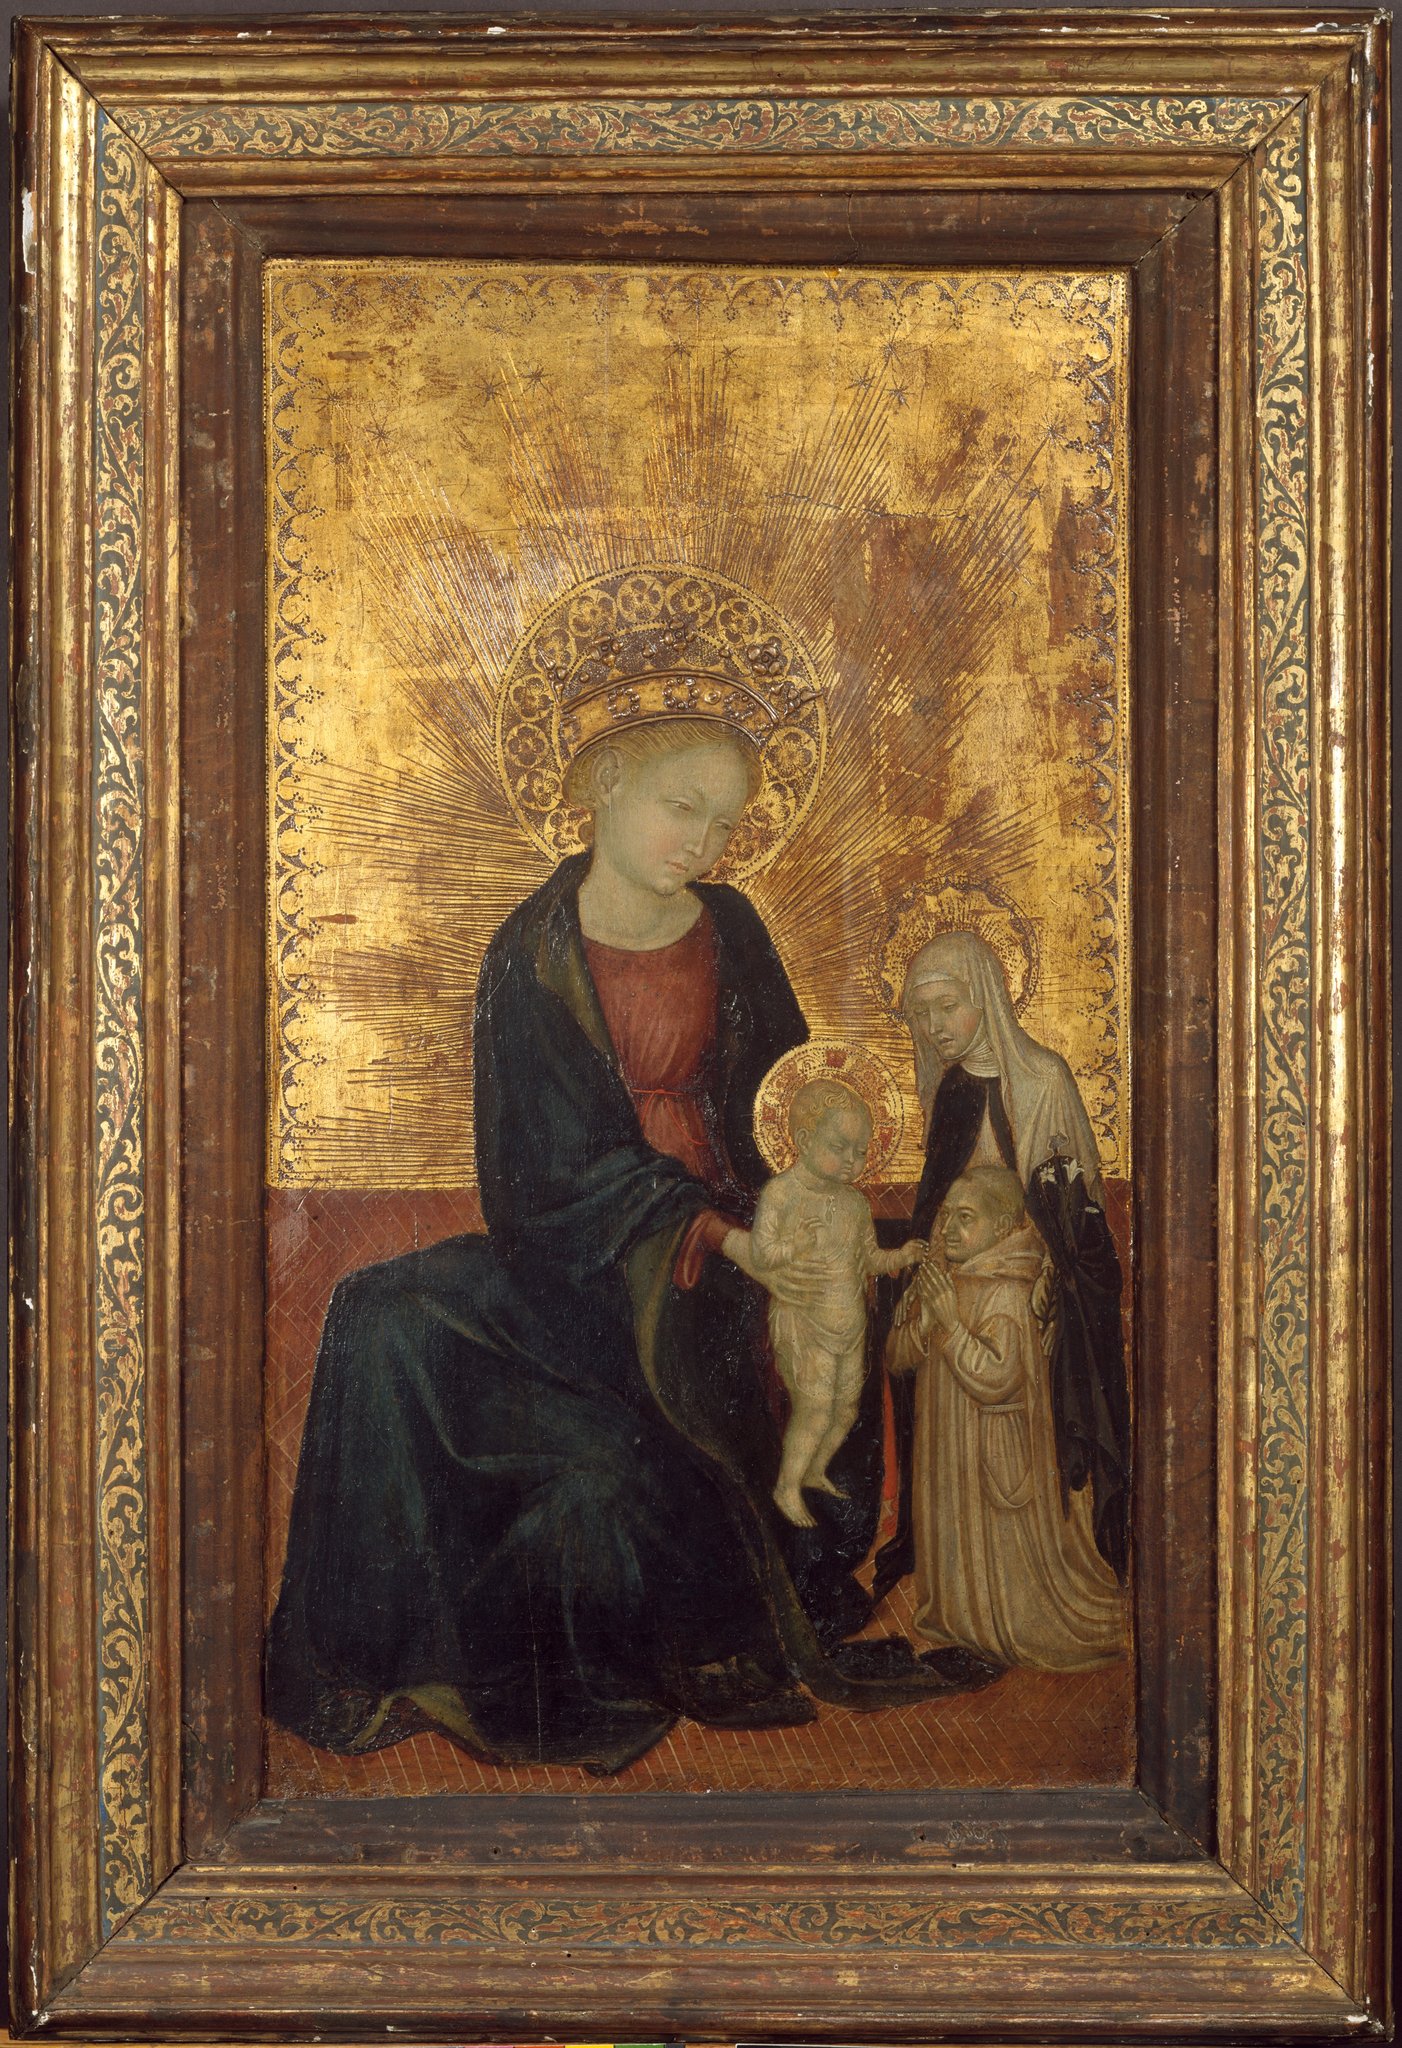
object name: painting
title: Madonna and Child with Saint Catherine of Siena and a Carthusian Donor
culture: italian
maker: italian, lombard (probably pavia)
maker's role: artist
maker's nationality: italian, lombard (probably pavia)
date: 1411-1424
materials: gold, paint, wood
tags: men,madonna and child,saint catherine